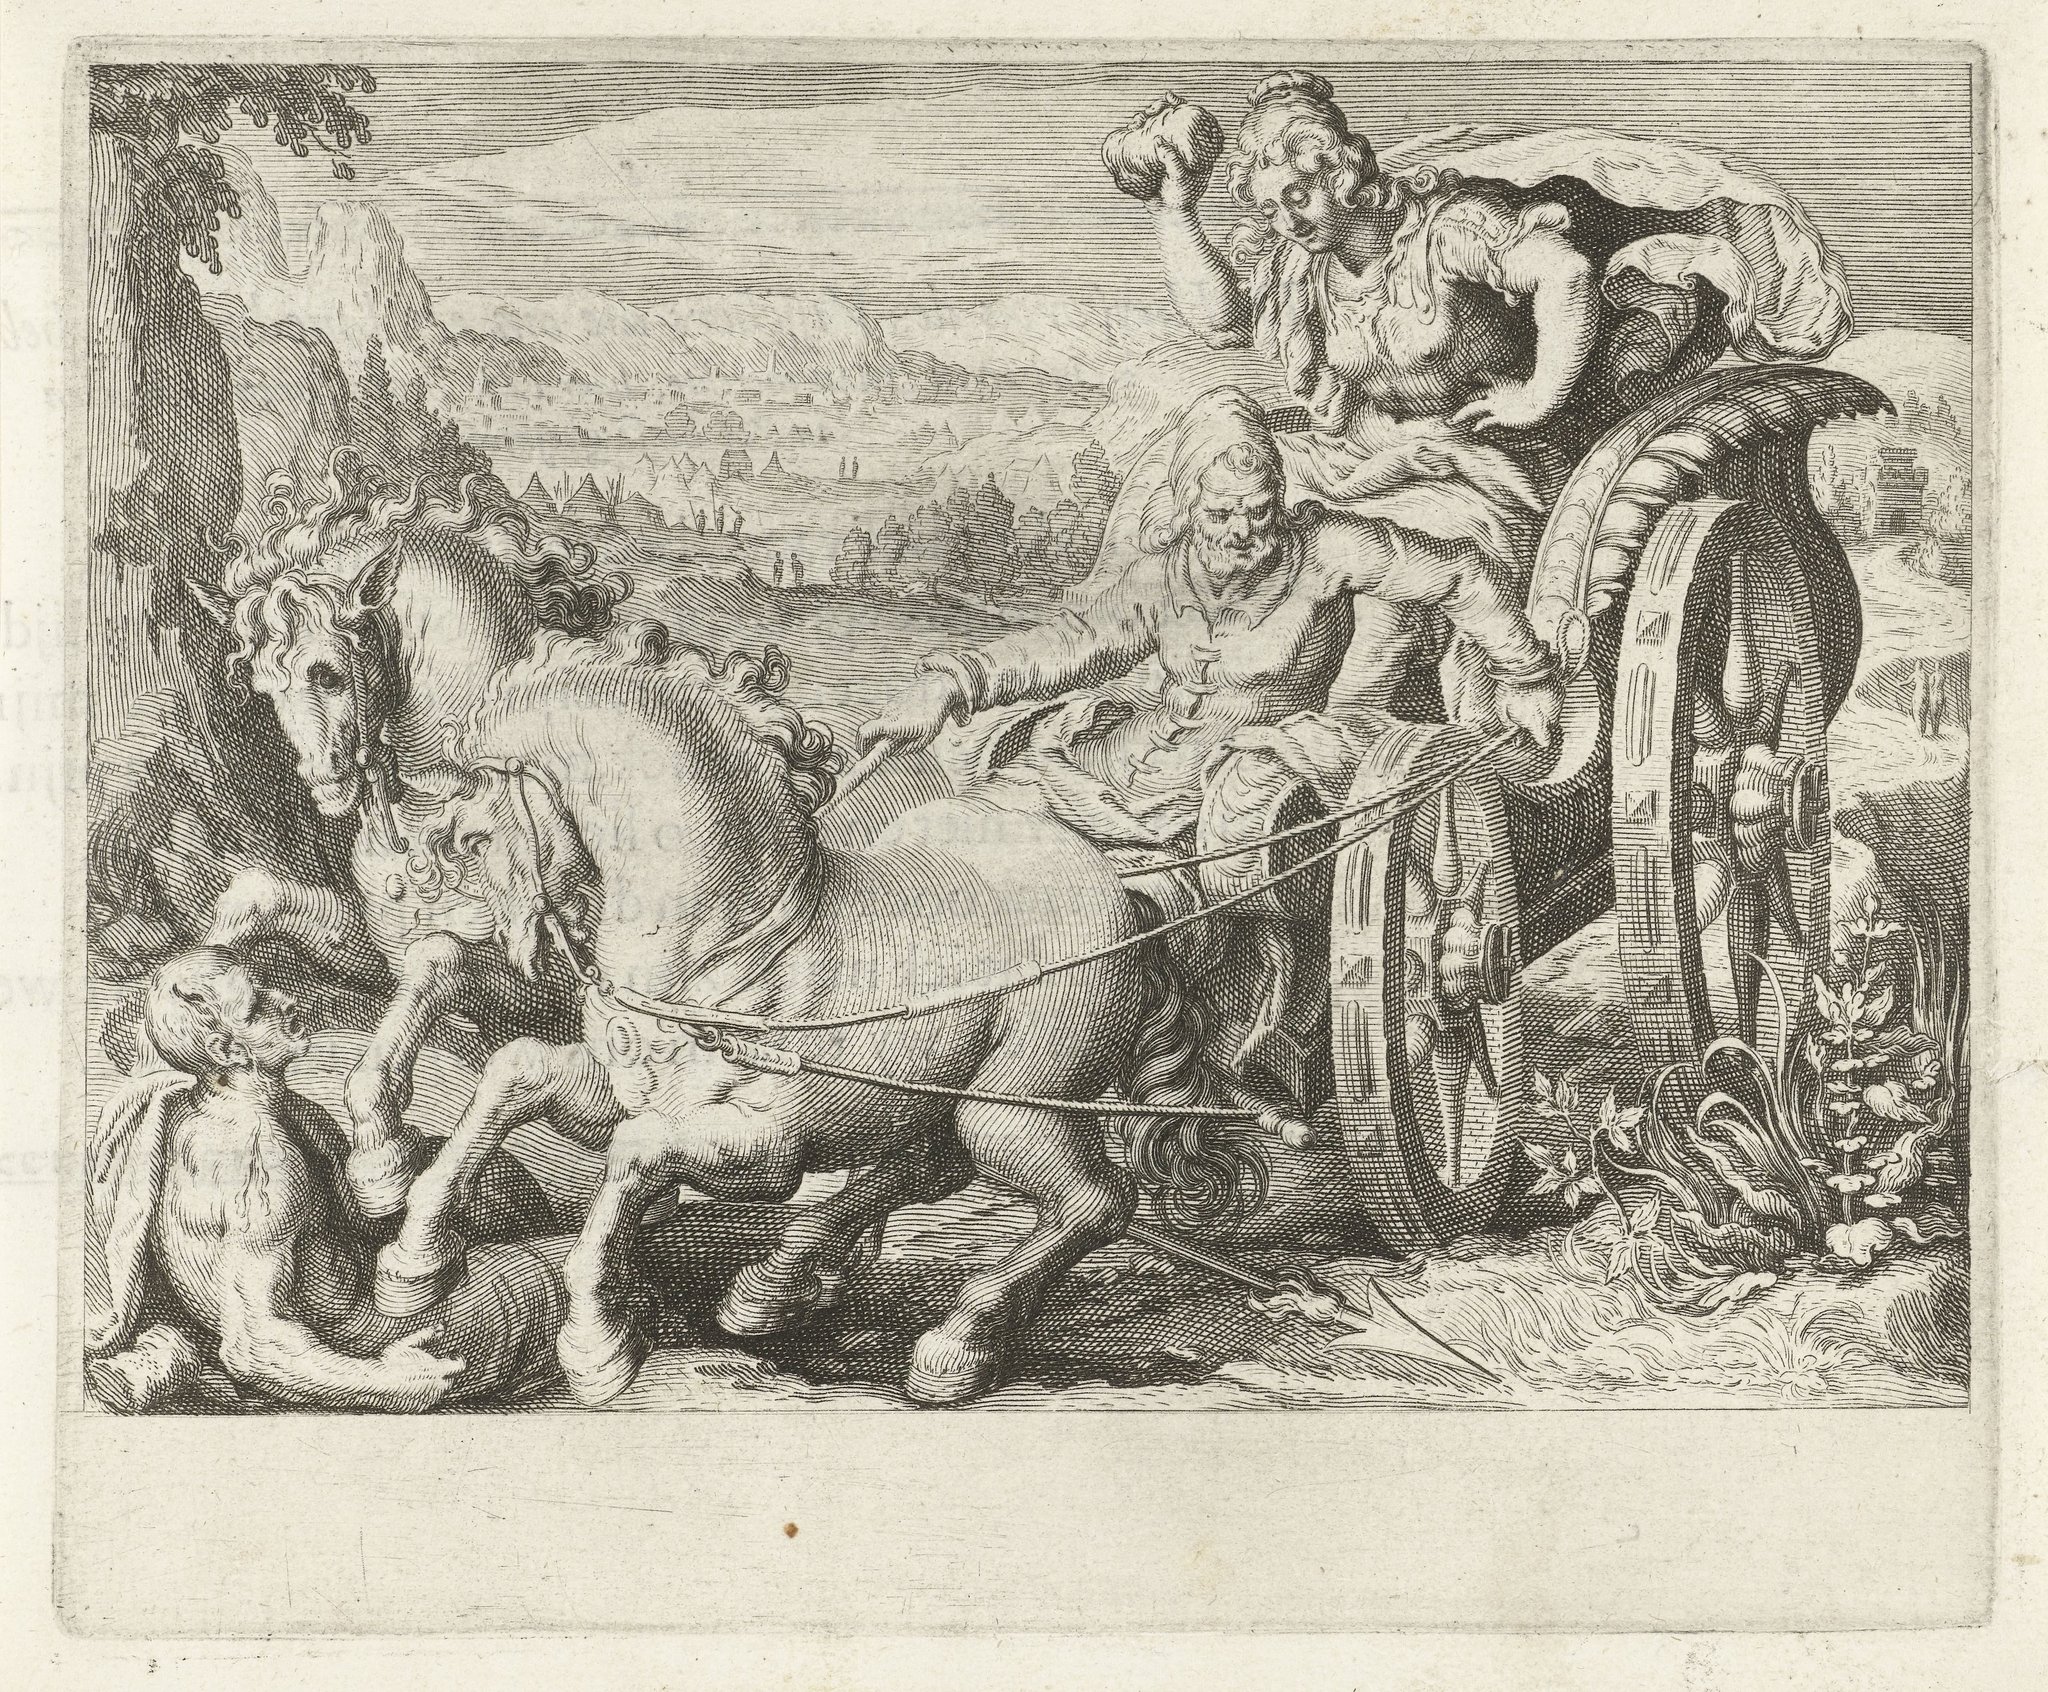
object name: book illustration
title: Beronica oefent wraak met een steen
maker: zacharias dolendo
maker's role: print maker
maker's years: 1561-1604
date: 1606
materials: paper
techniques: engraving, letterpress printing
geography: leiden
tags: passenger carriage, violent death by stoning, blood-revenge, vendetta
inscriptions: collector's mark: Lugt 2228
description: Beronica wreekt haar vermoorde zoon door zijn moordenaars te slaan met een steen. Beronica zit in een koets die bestuurd wordt door Caeneus, een van de moordenaars. De bestuurder raakt de teugels kwijt en de paarden rennen over een man met duivelsoren, de tweede moordenaar van haar zoon. Bladzijde uit een boek met tekst op het verso.